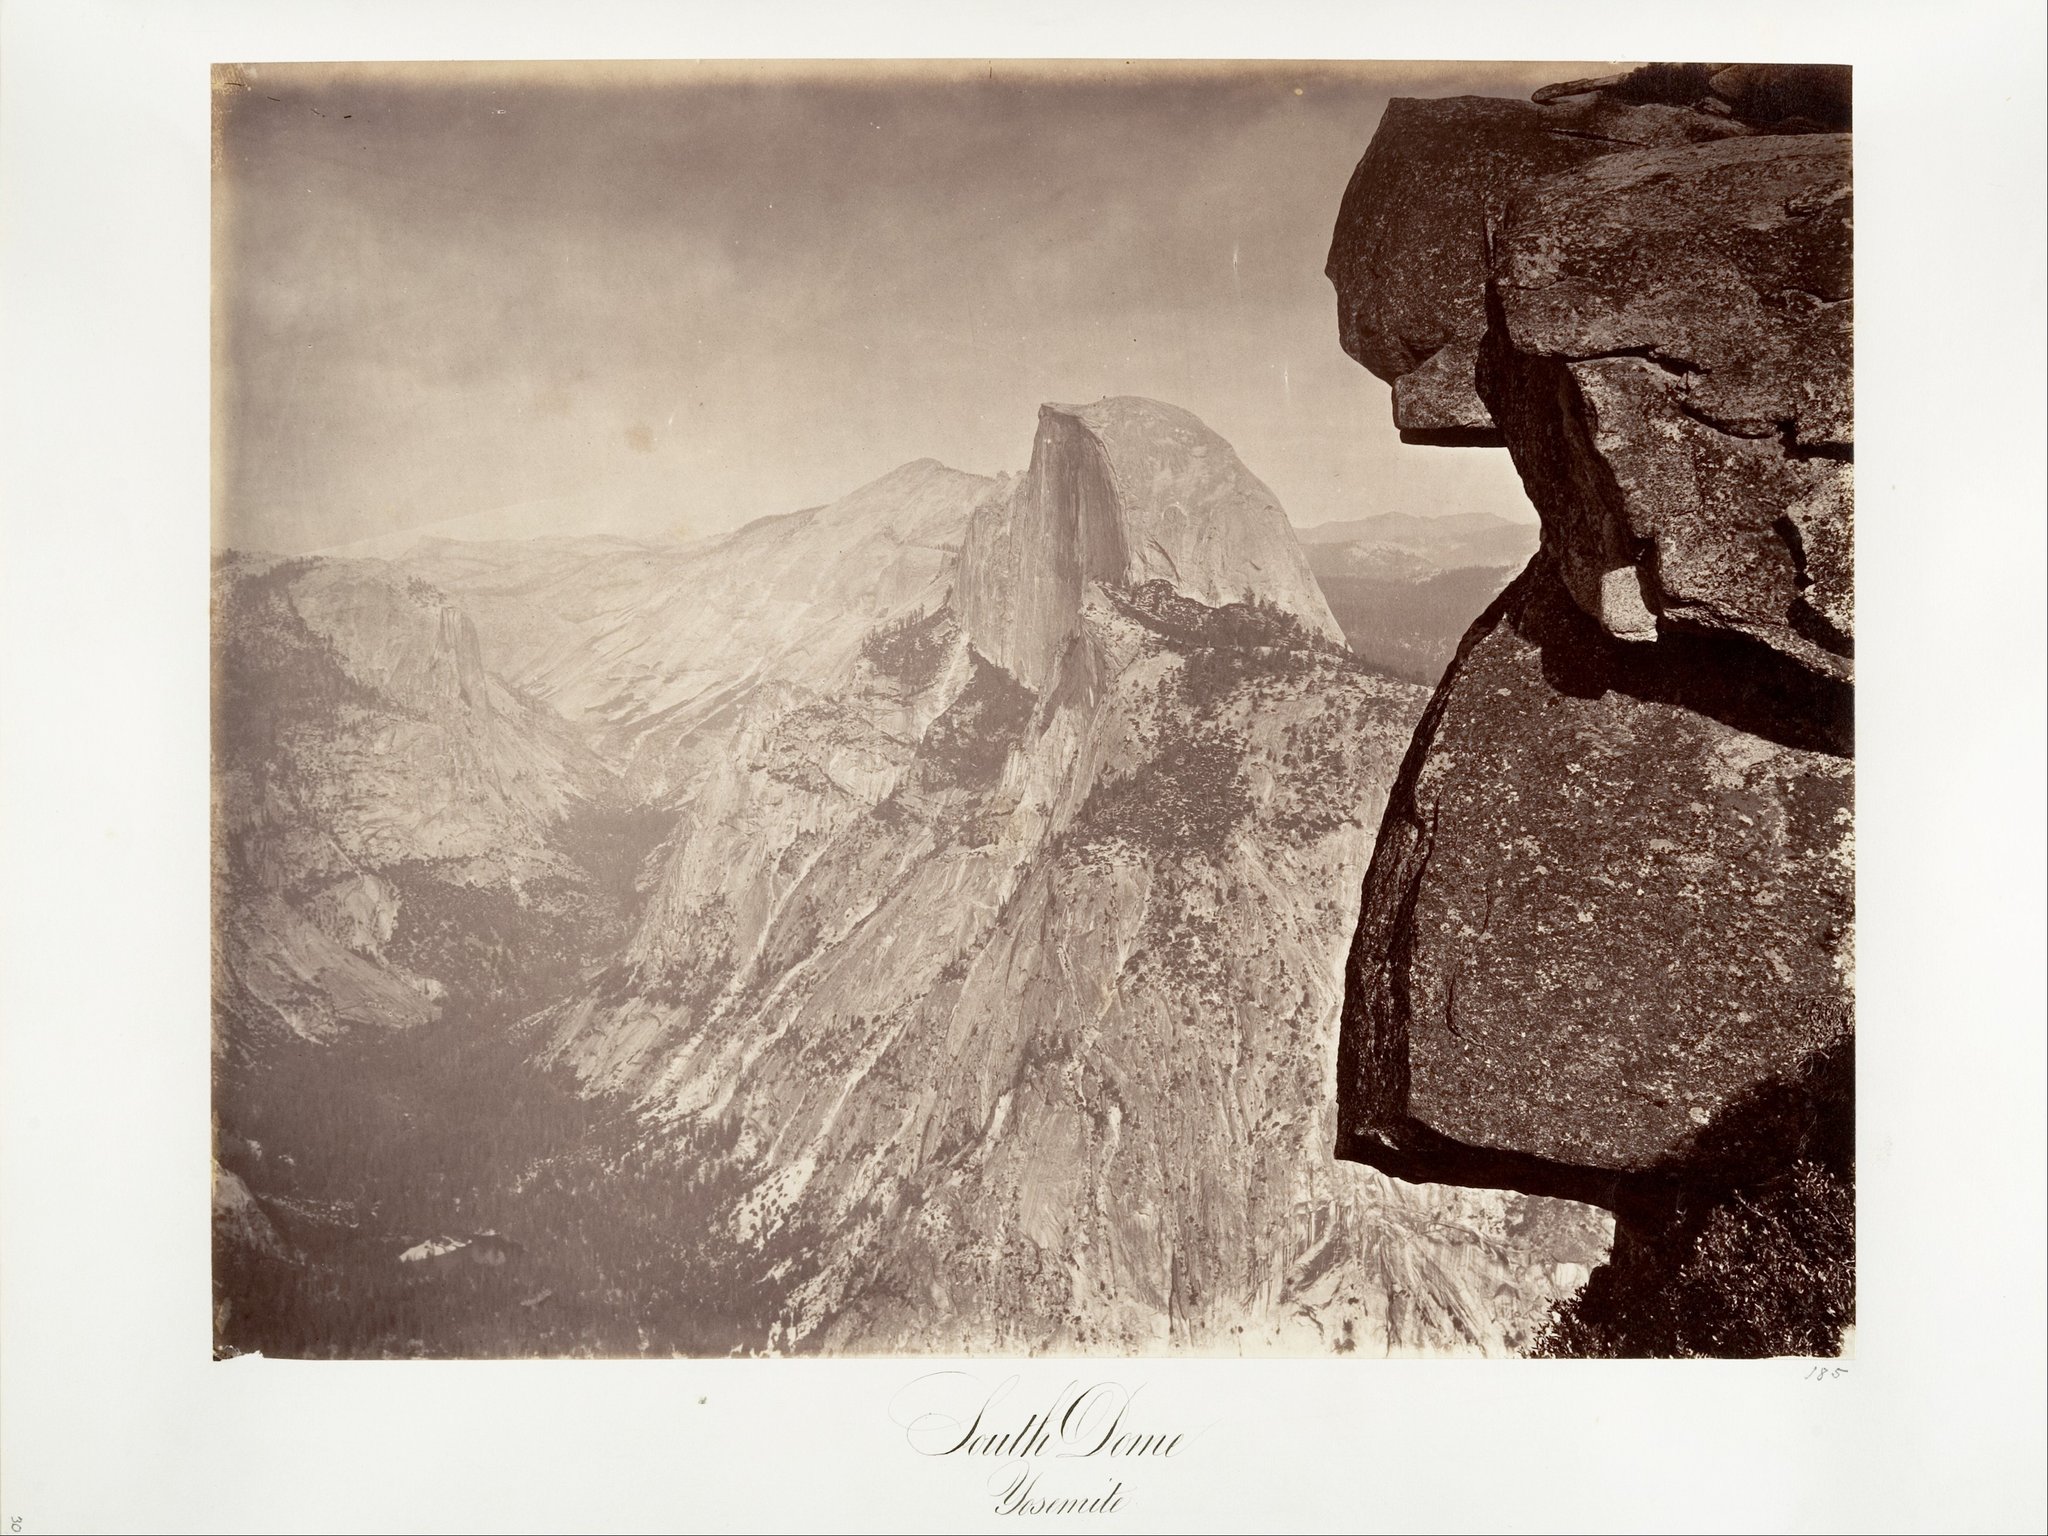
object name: photograph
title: South Dome, Yosemite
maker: carleton e. watkins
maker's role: artist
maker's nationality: american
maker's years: 1829-1916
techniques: albumen silver print, glass negative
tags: mountains,landscapes